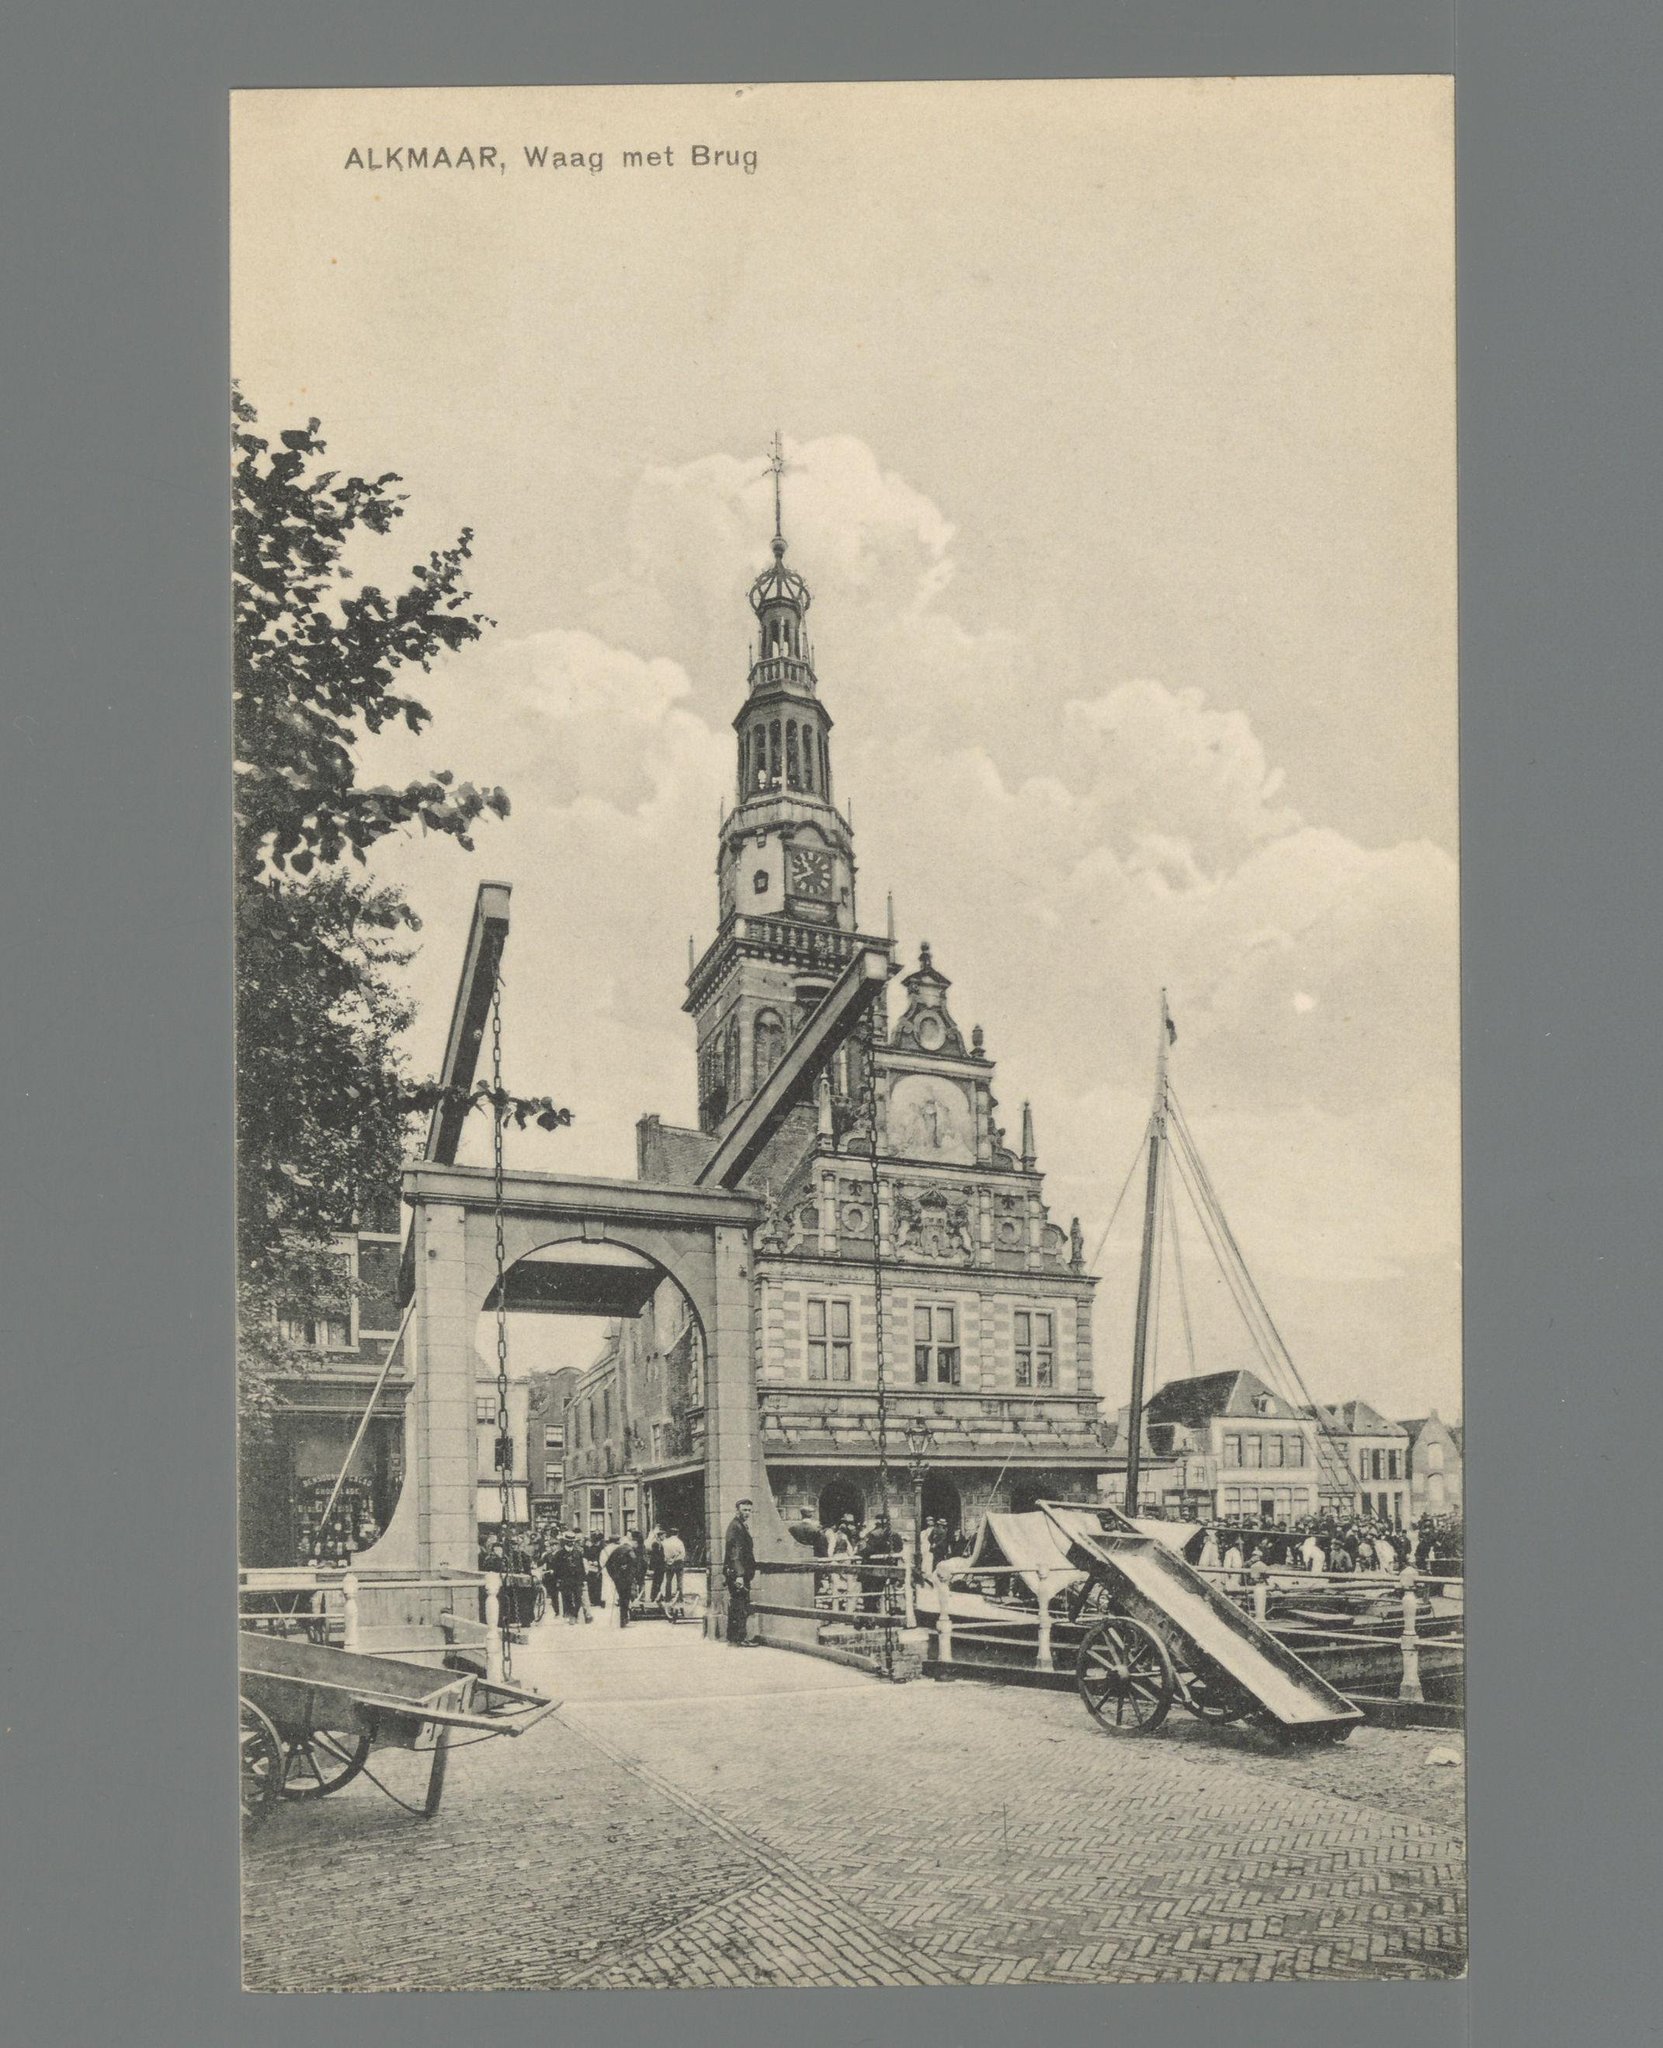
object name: ansichtkaart, prentbriefkaart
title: Alkmaar, Waag met brug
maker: Anonymous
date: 1906-1930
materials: cardboard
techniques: photograph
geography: alkmaar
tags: city-view, and landscape with man-made constructions, tower, clock tower ~ monumental adornment, bridge in city across river, canal, etc.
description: Mogelijk gedateerd 1919 op verso, eerste twee cijfers van het getal.